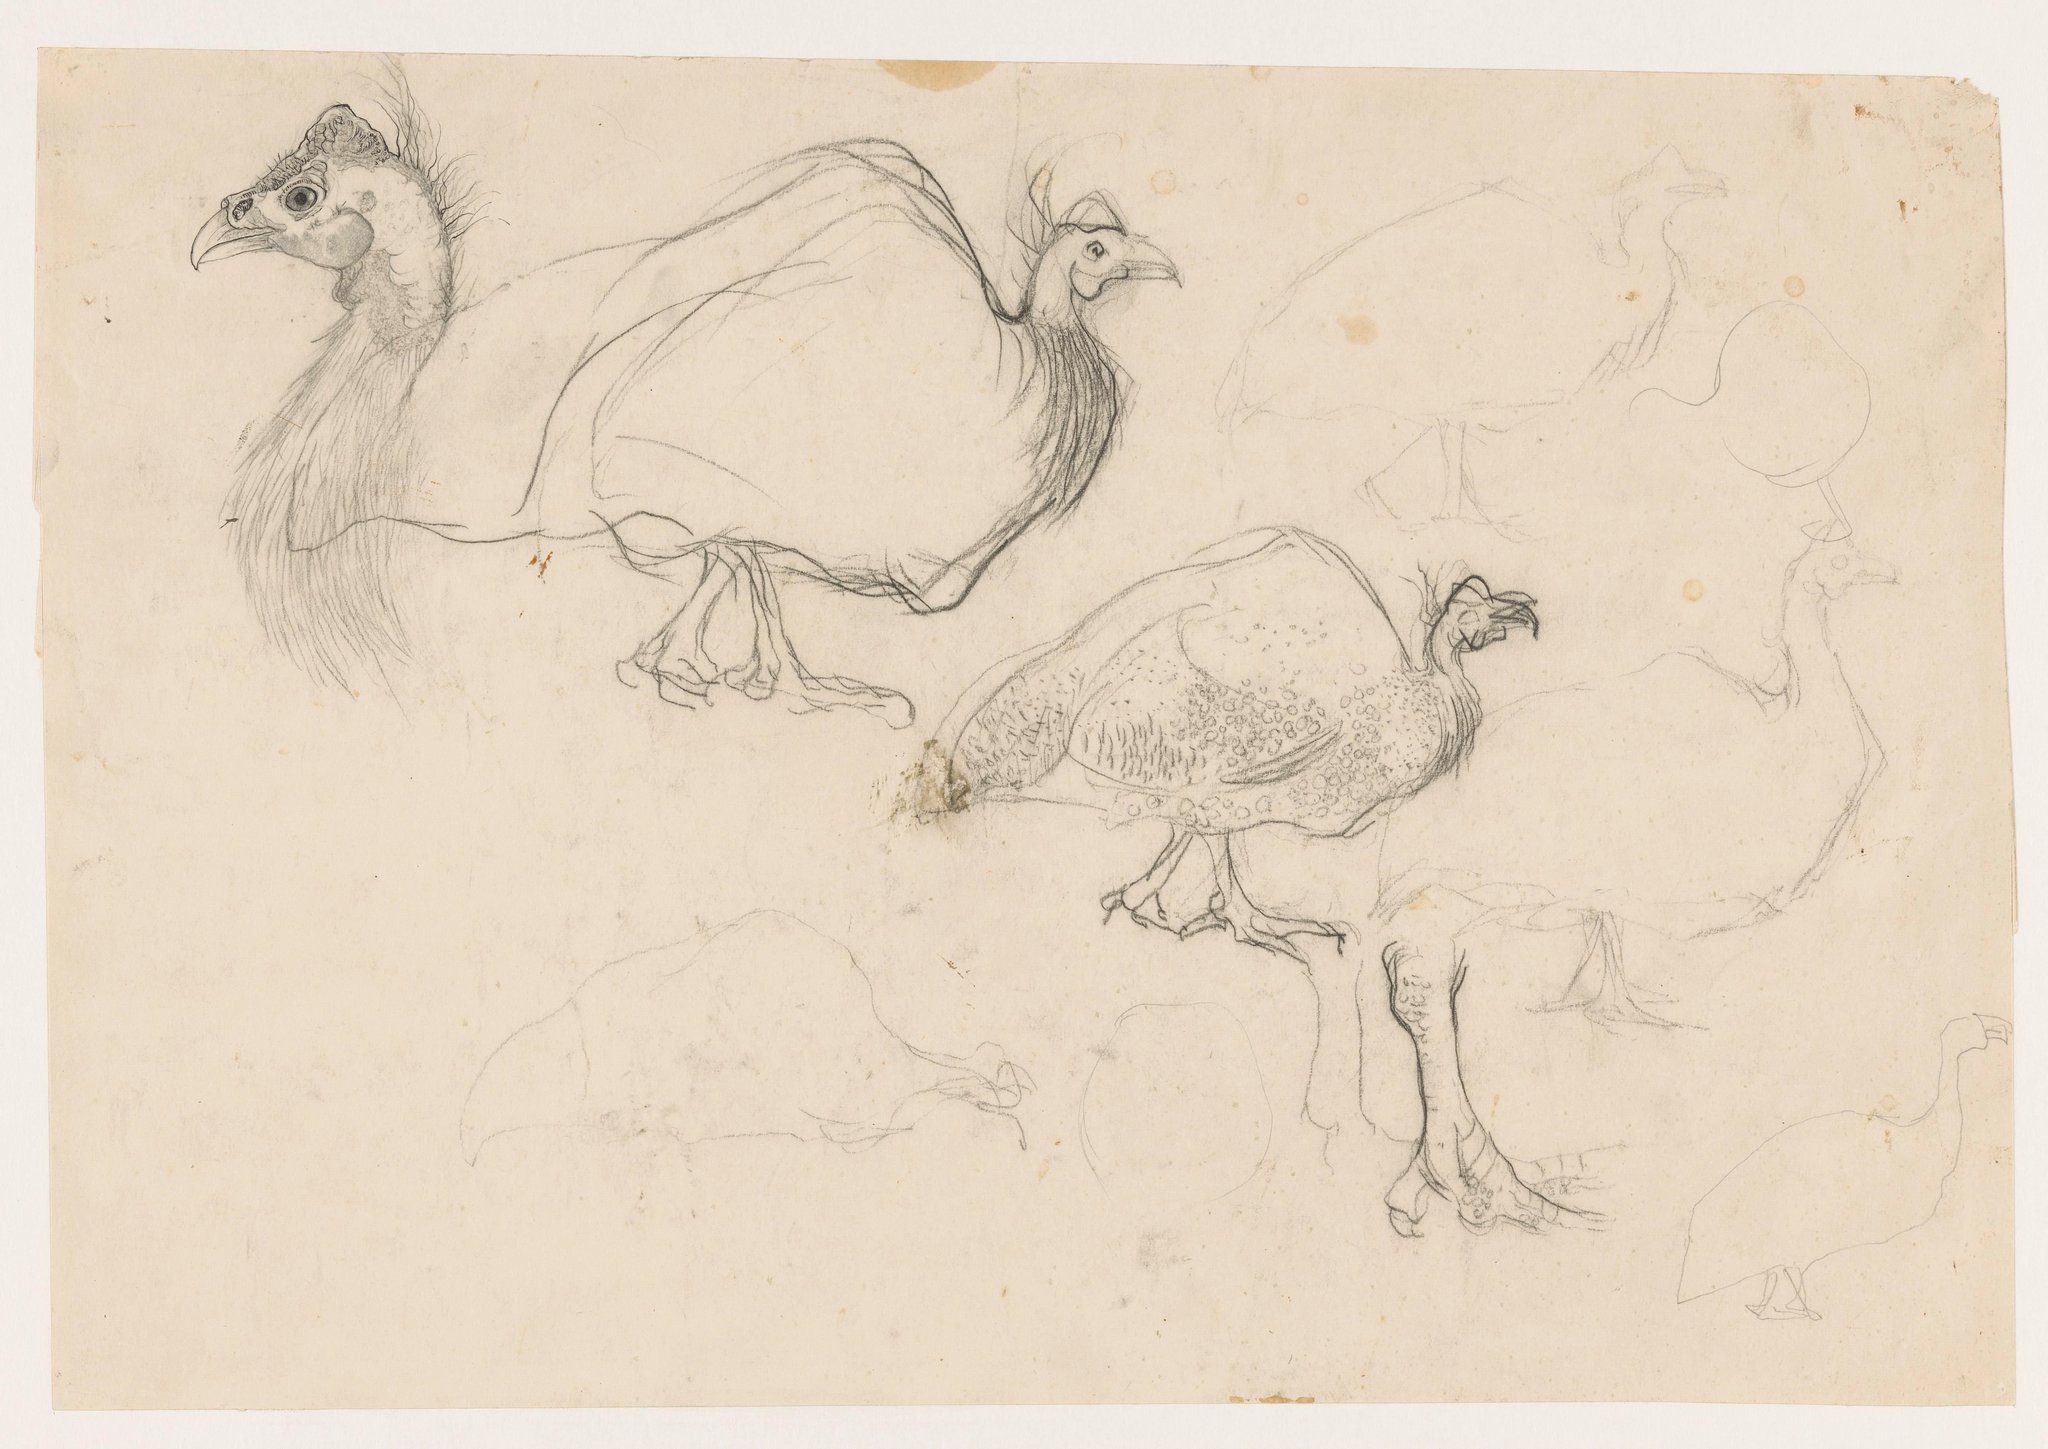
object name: voorstudie prent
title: Studieblad met parelhoenen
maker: jan mankes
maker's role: draughtsman, painter, print maker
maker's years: 1889-1920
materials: chalk, ink, paper, pencil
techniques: pen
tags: walker and runner birds: guineafowl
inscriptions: collector's mark: Lugt 2228